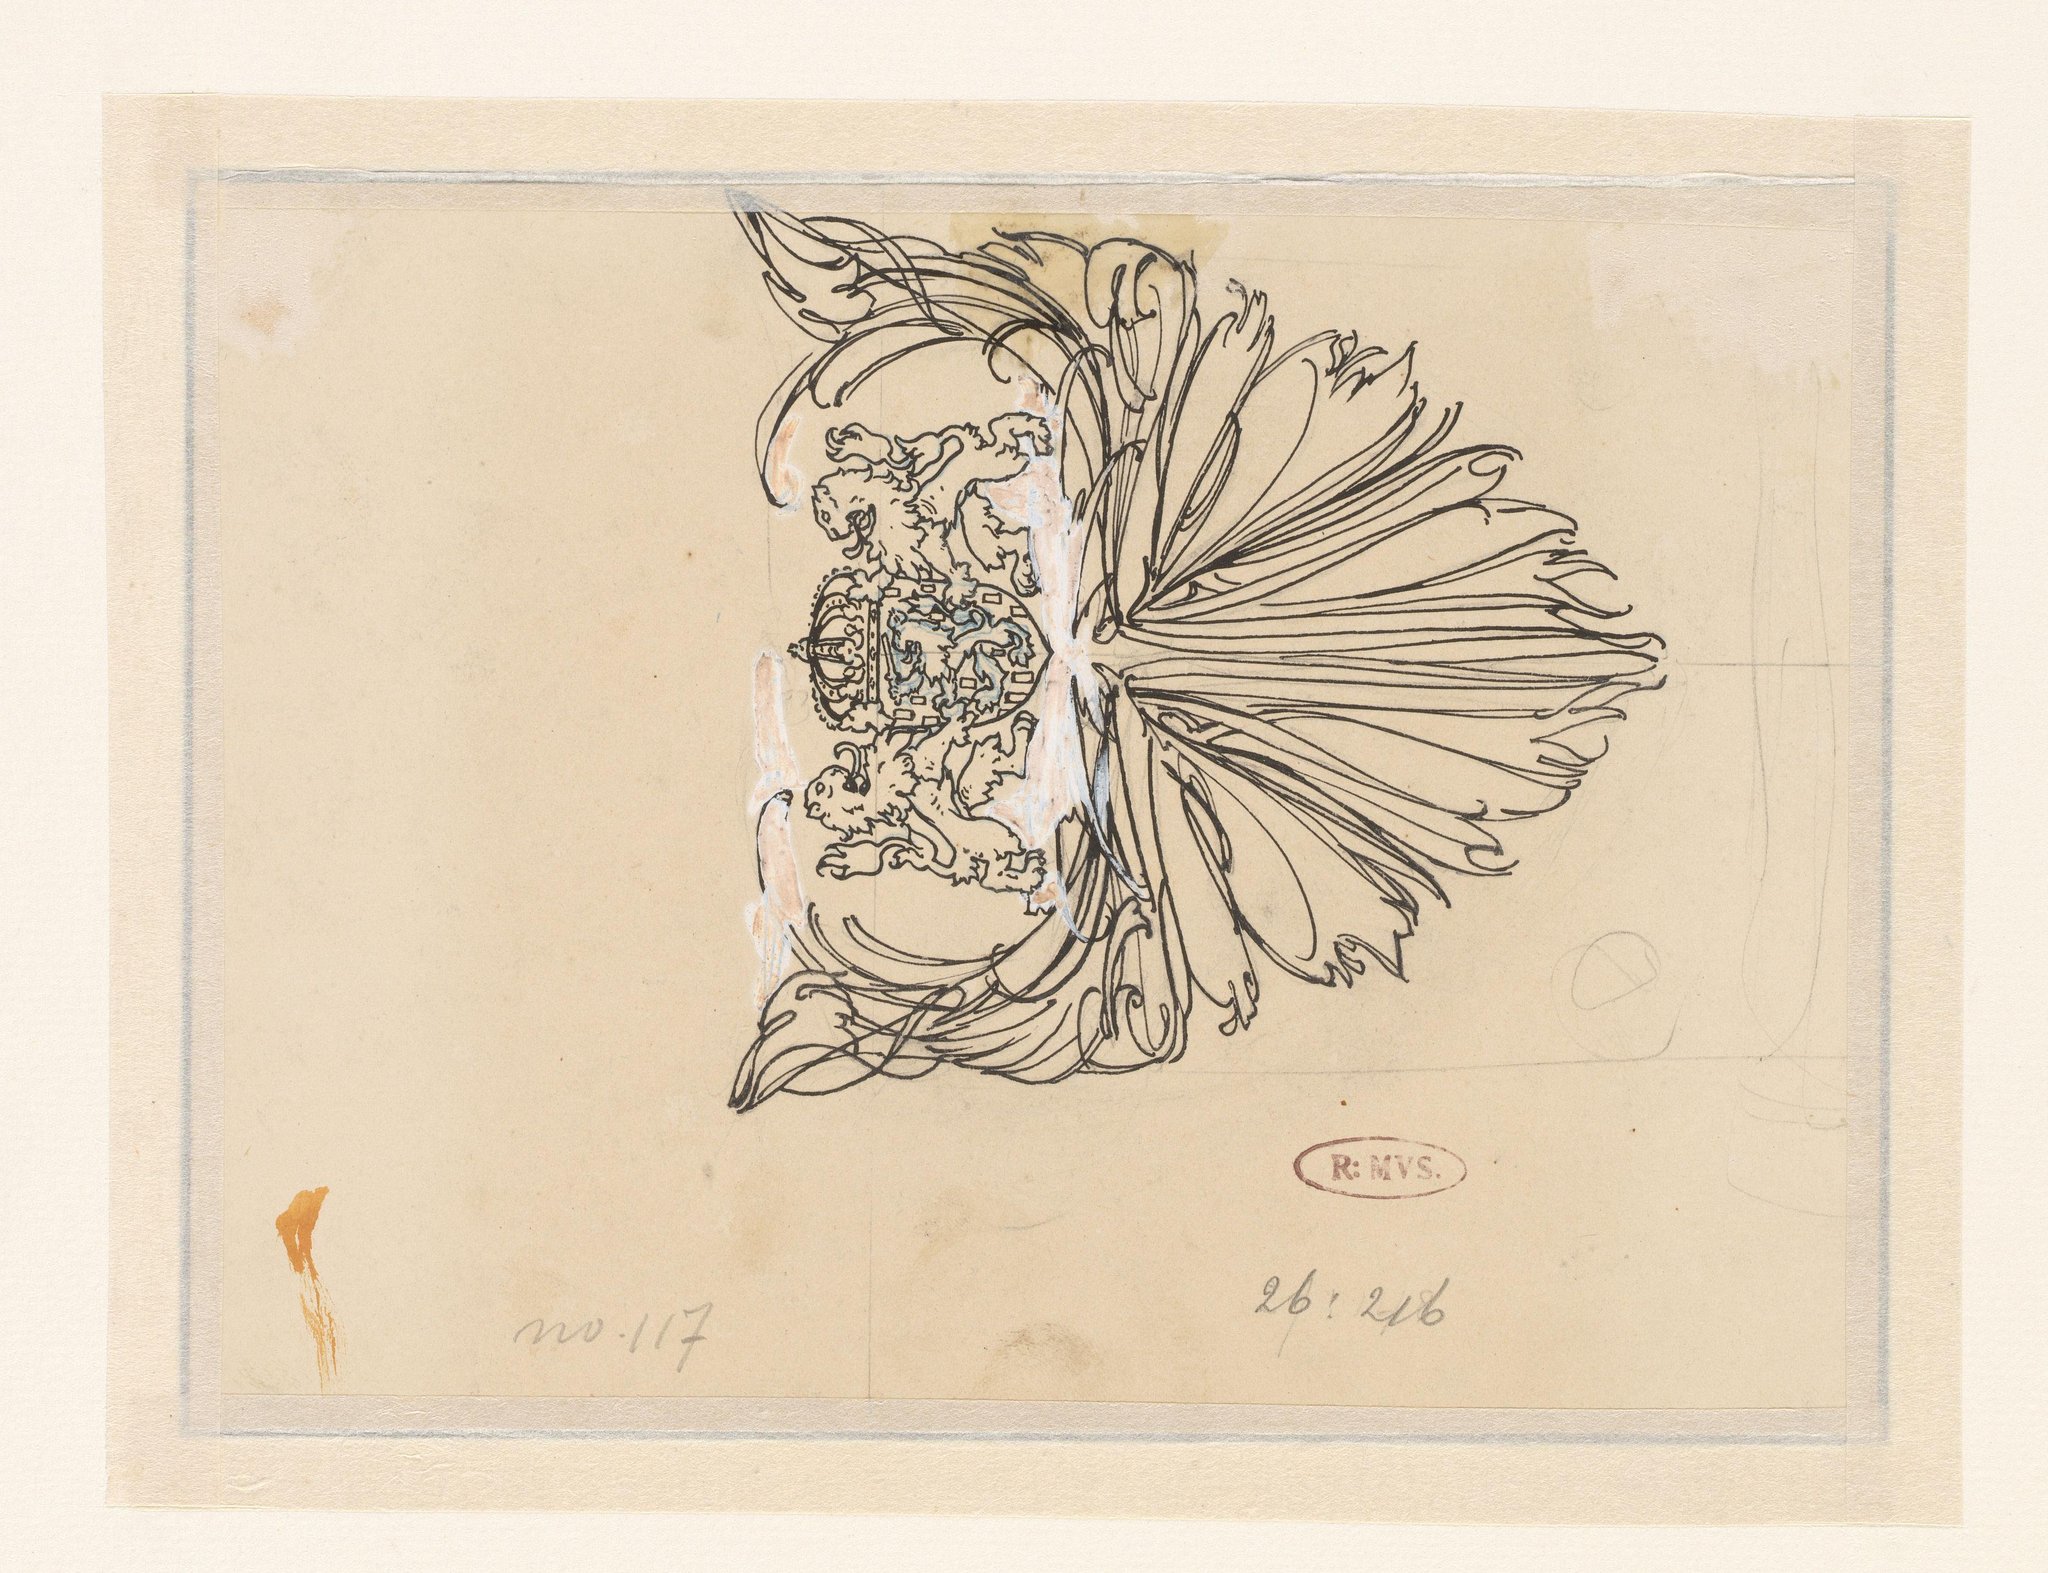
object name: drawing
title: Ornament met wapen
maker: willem wenckebach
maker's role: designer, draughtsman, painter, print maker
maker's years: 1860-1937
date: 1870-1926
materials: paint, ink, paper, pencil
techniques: pen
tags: street, amsterdam